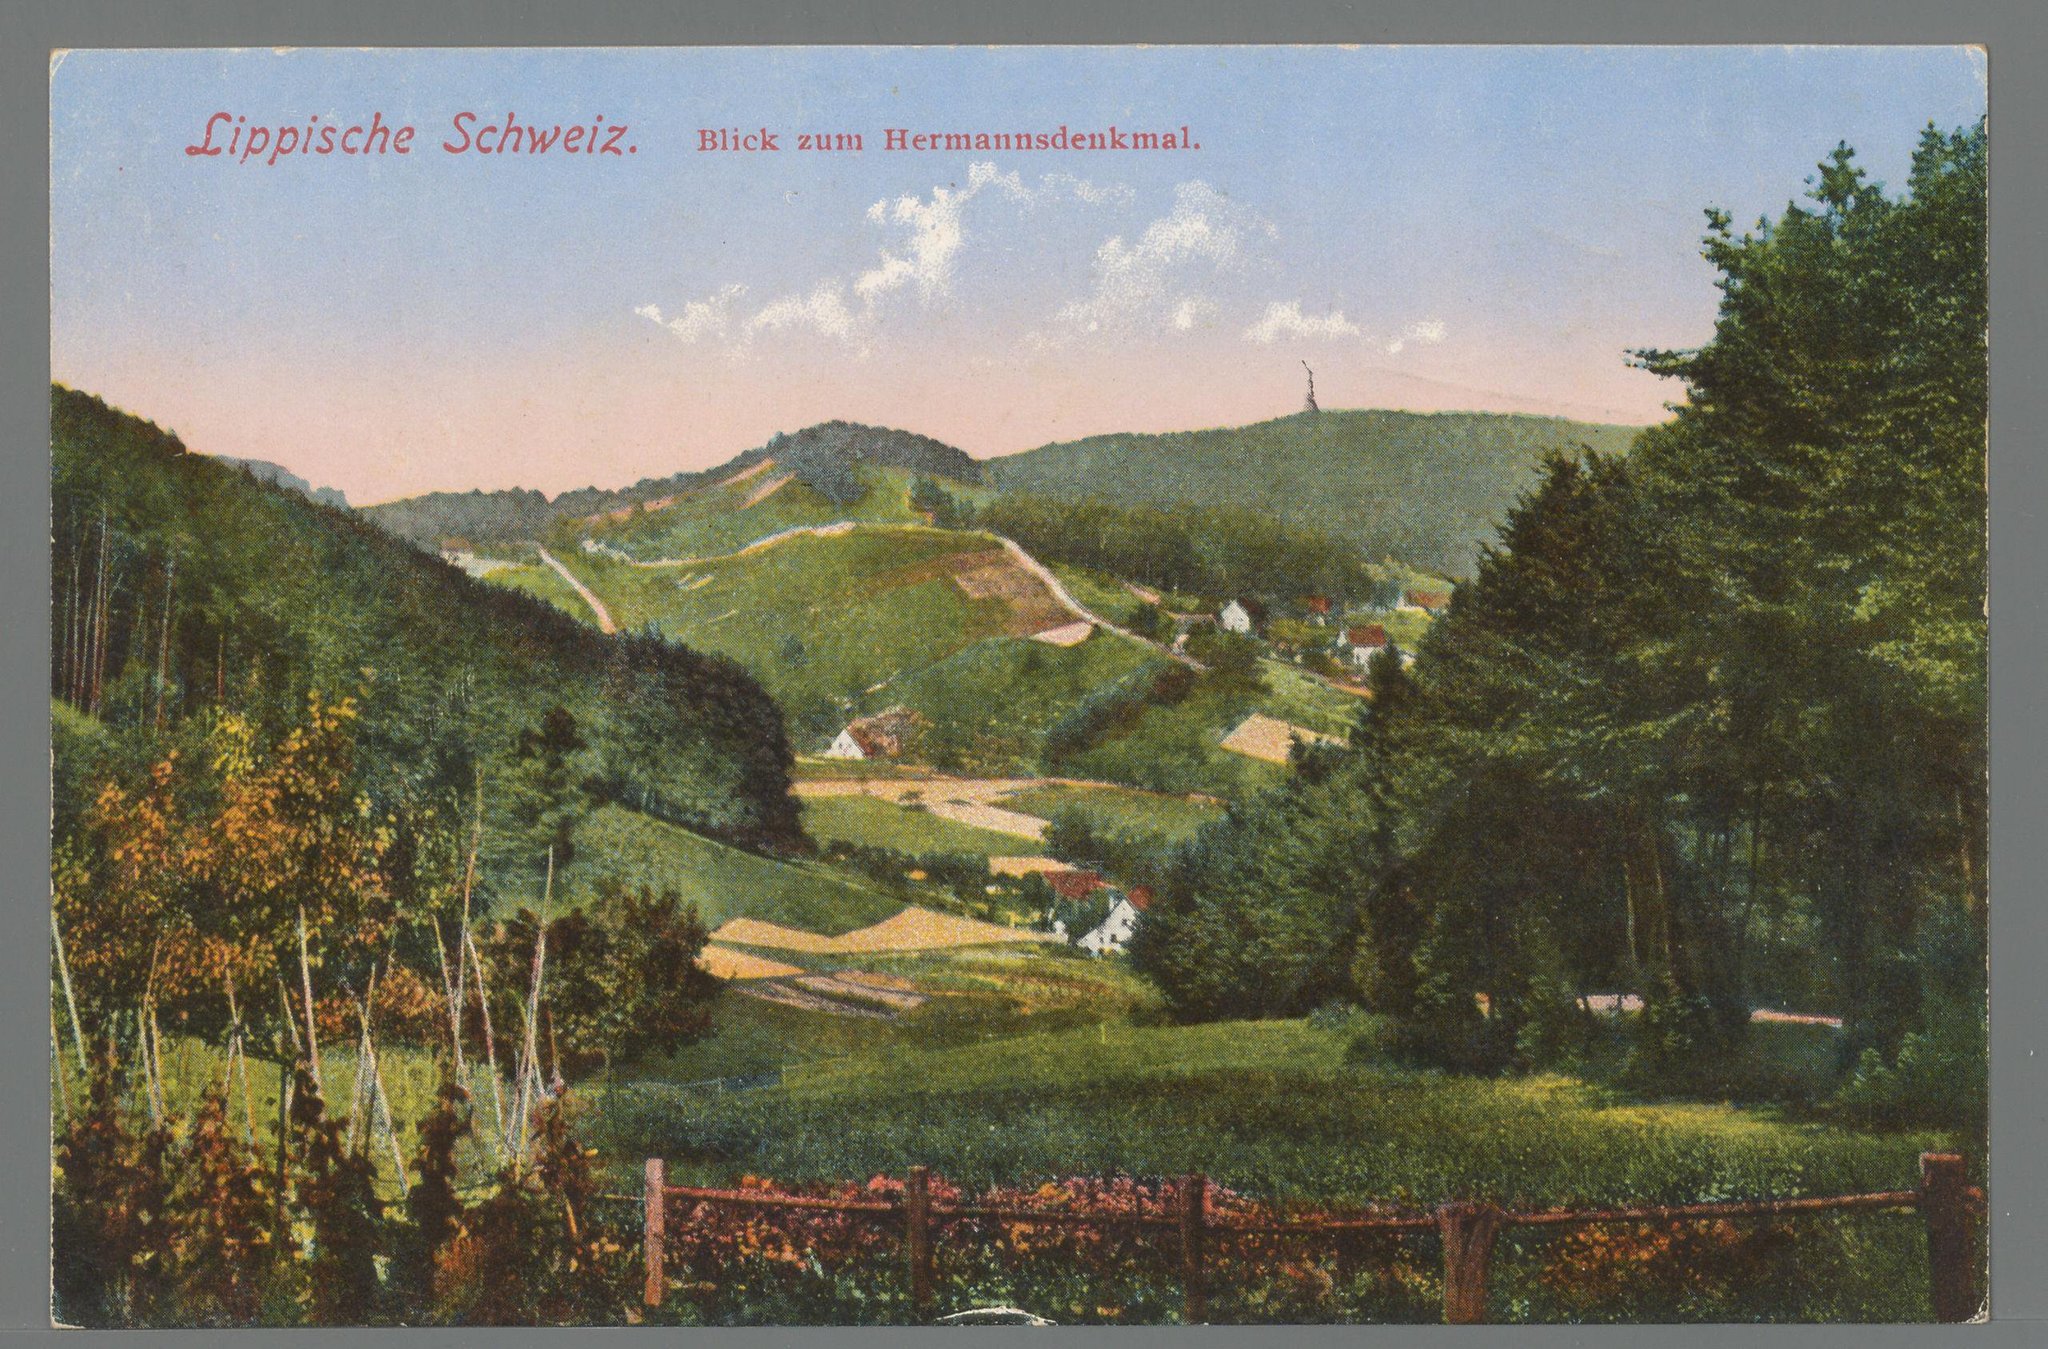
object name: photomechanical print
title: Lippische Schweiz. Blick zum Hermannsdenkmal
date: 1905-1926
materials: cardboard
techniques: lithograph, writing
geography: leipzig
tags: dale, valley, monument, statue